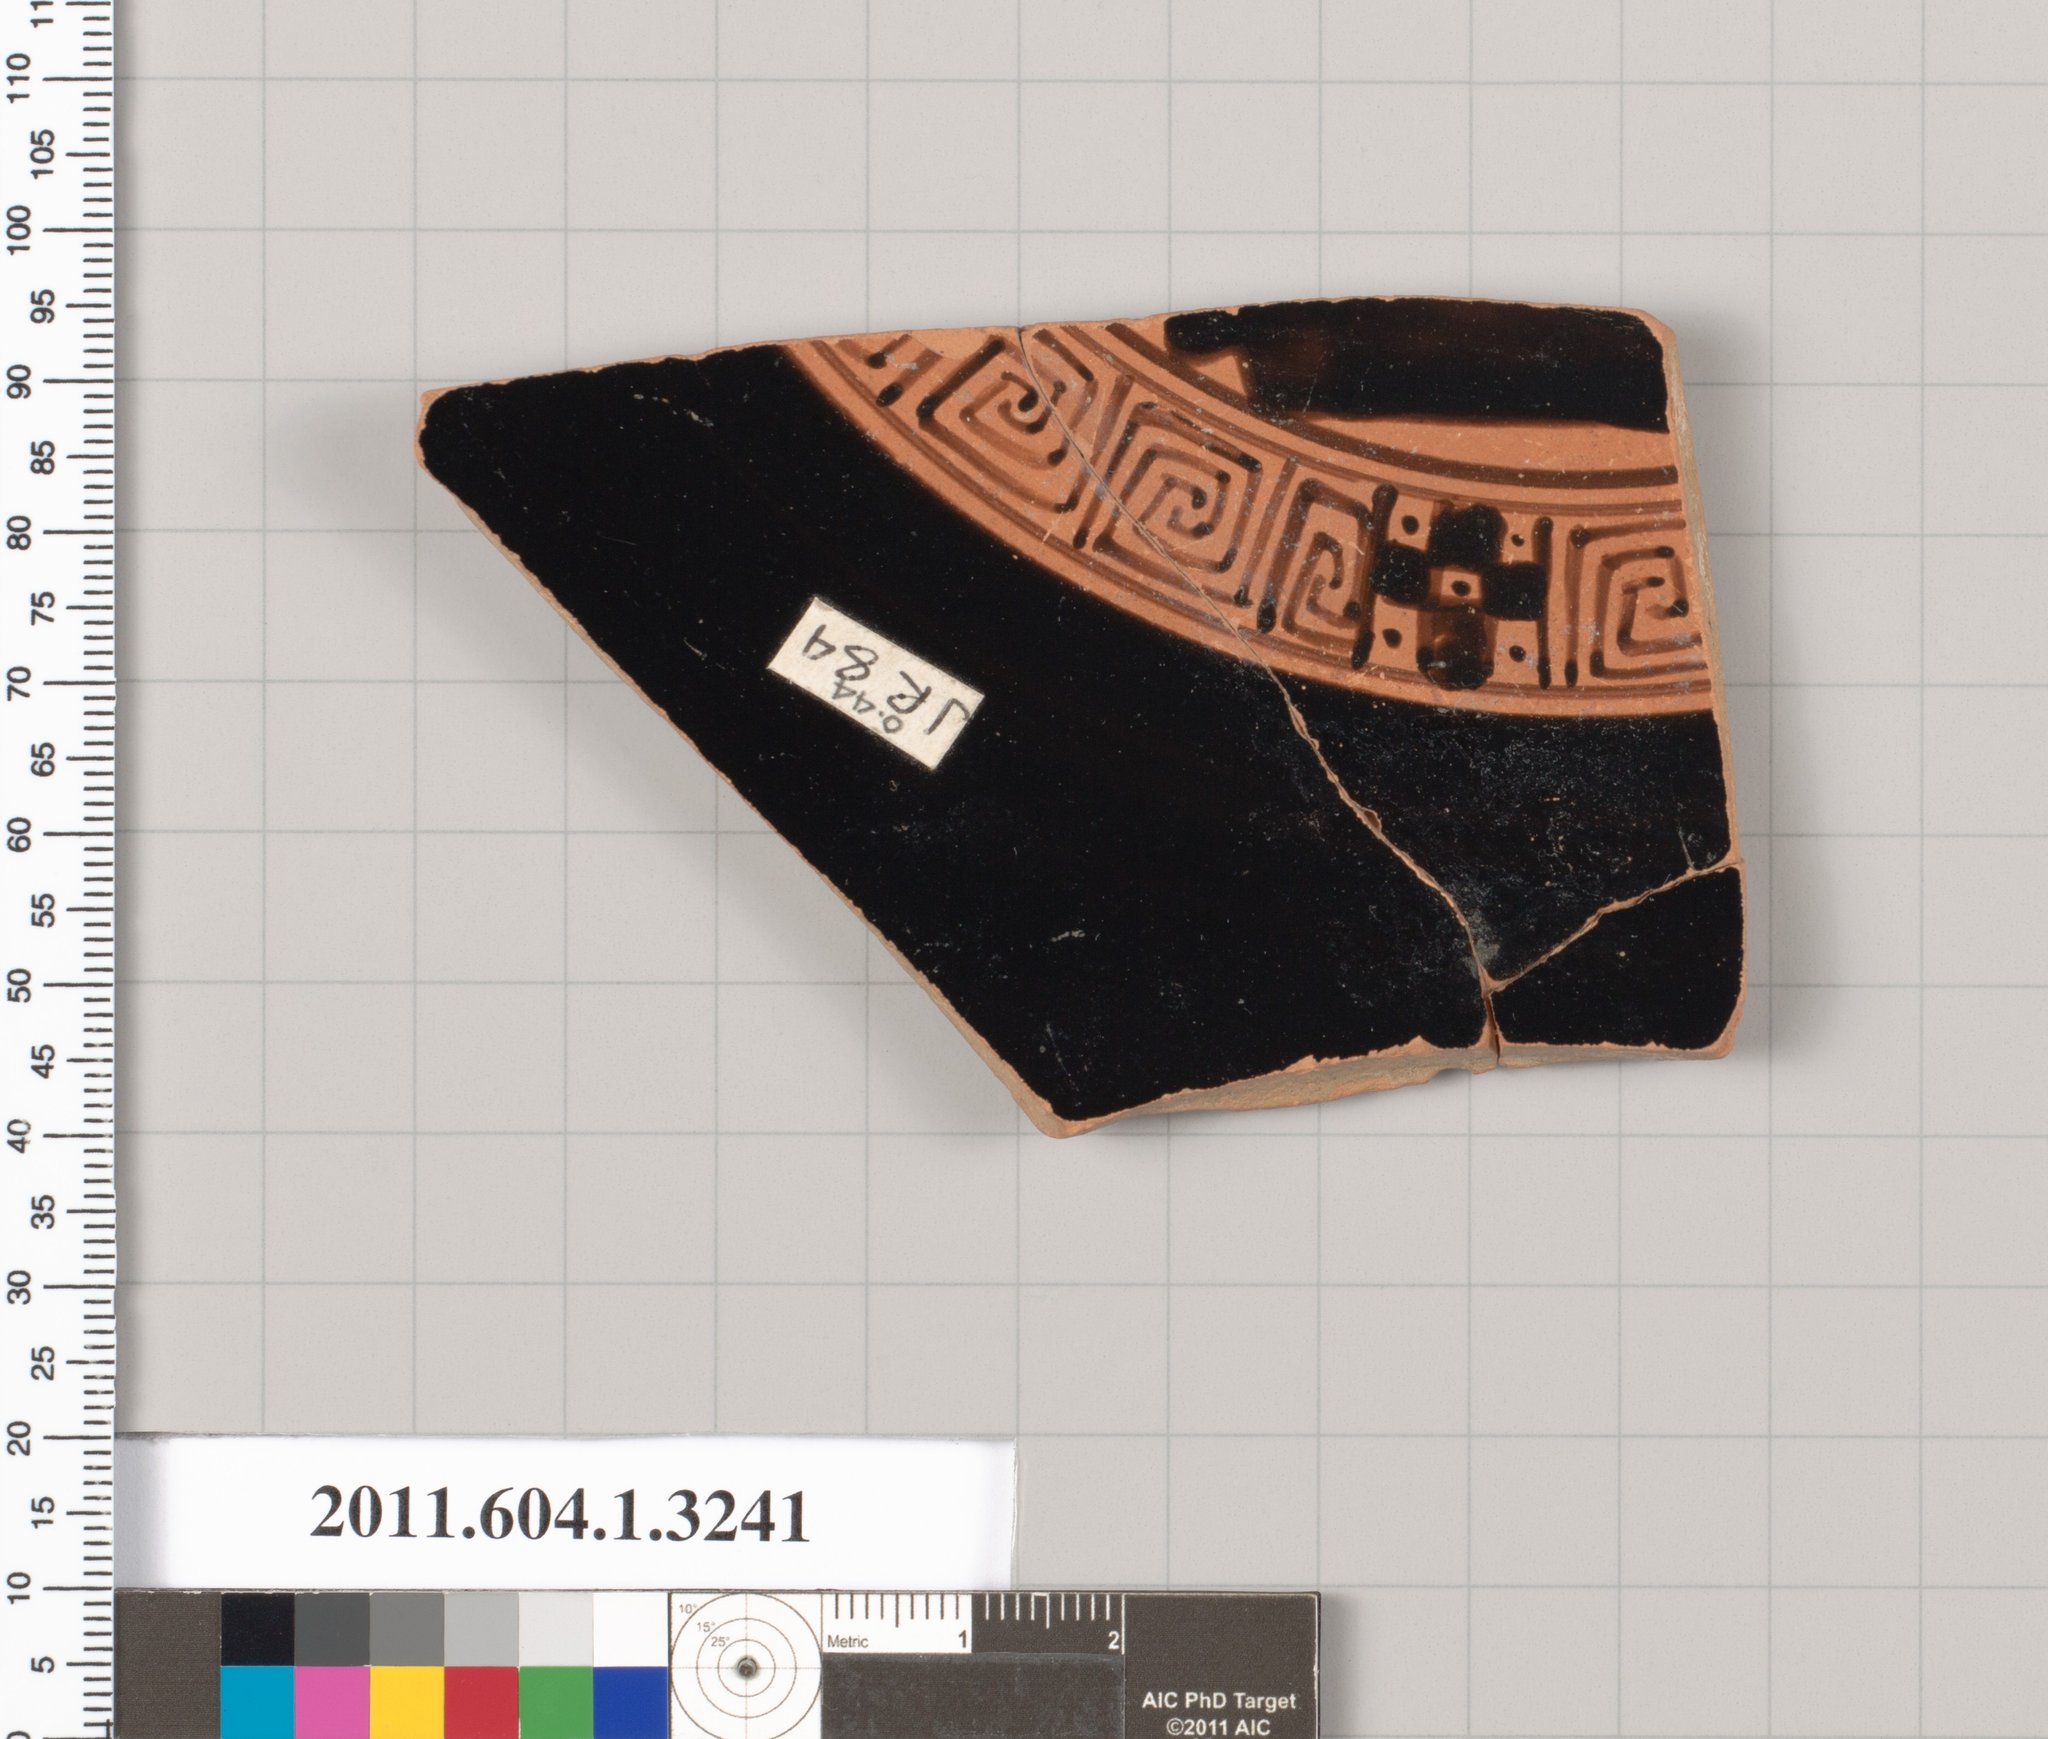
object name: kylix fragment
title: Terracotta fragment of a kylix (drinking cup)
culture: greek, attic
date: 475-451 BCE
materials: terracotta